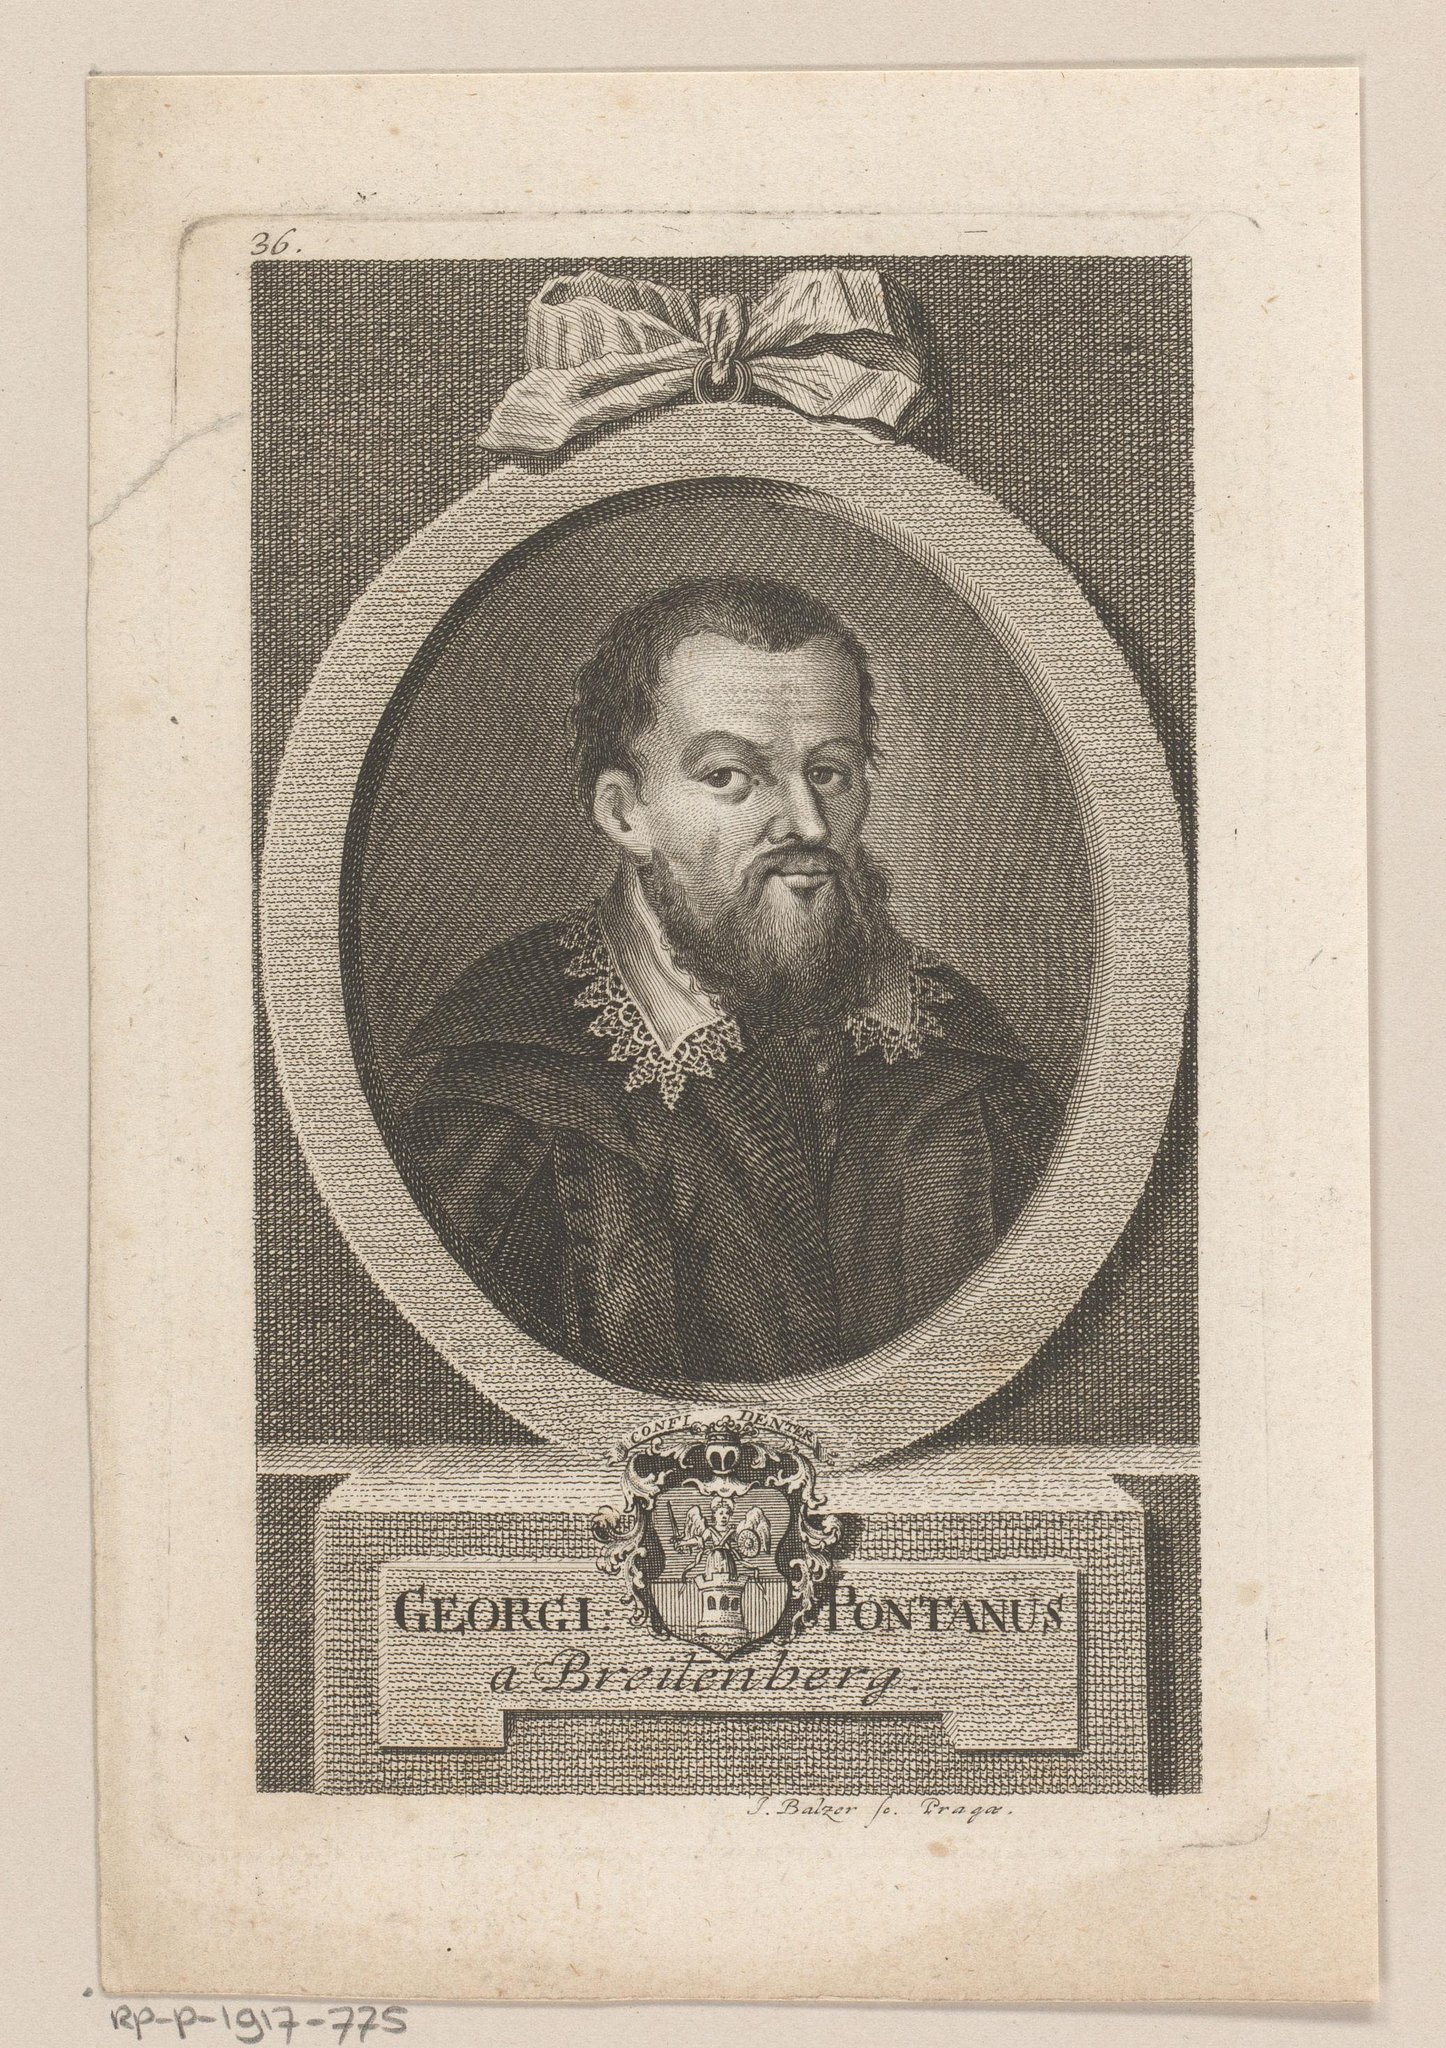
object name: print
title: Portret van Georg Barthold Pontanus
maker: jan balzer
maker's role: print maker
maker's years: 1736-1799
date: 1775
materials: paper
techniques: engraving, etching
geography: prague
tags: georg barthold pontanus, historical persons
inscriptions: collector's mark: Lugt 2228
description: Prent waarschijnlijk uit: Voigt, Adauctus. Effigies virorum eruditorum, atque artificum Bohemae et Moraviae, una cum brevi vitae operumque ipsorum enarratione. Praag: Wolffgang Gerle, 1775, dl. 2.